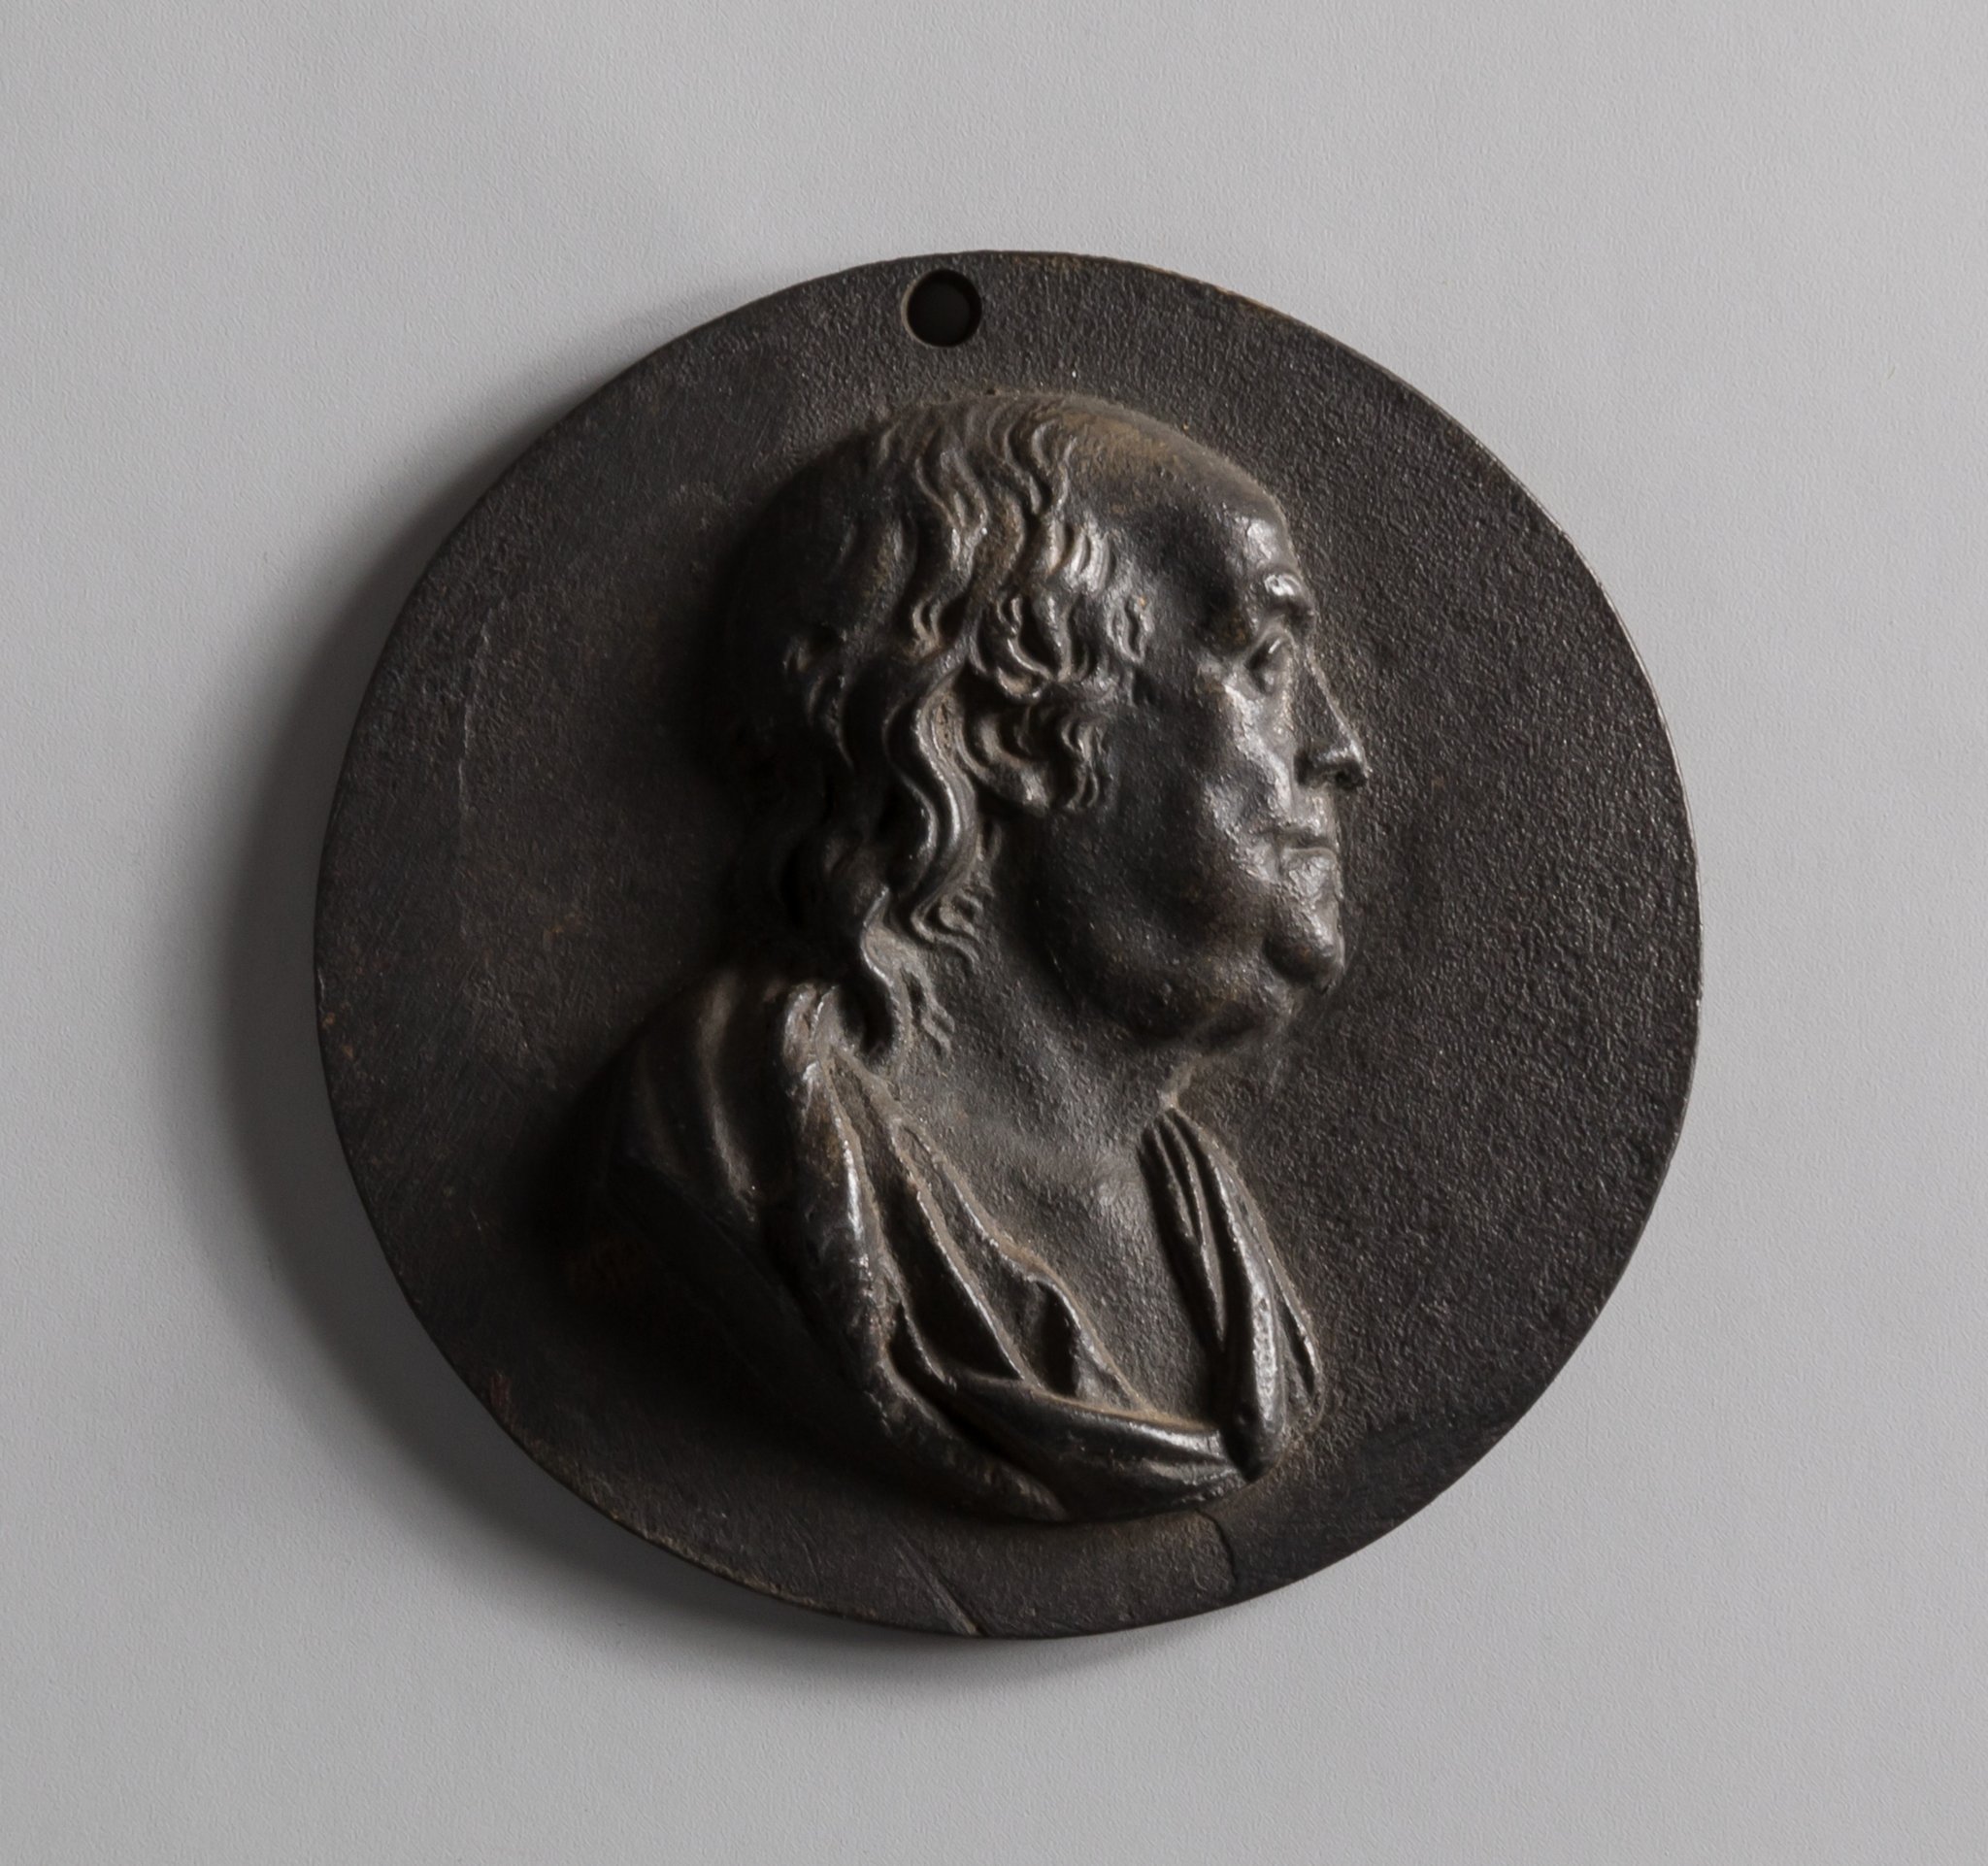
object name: medallion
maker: augustin dupré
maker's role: artist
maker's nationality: french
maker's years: 1748-1833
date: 1776-1883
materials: iron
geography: france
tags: benjamin franklin,men,profiles